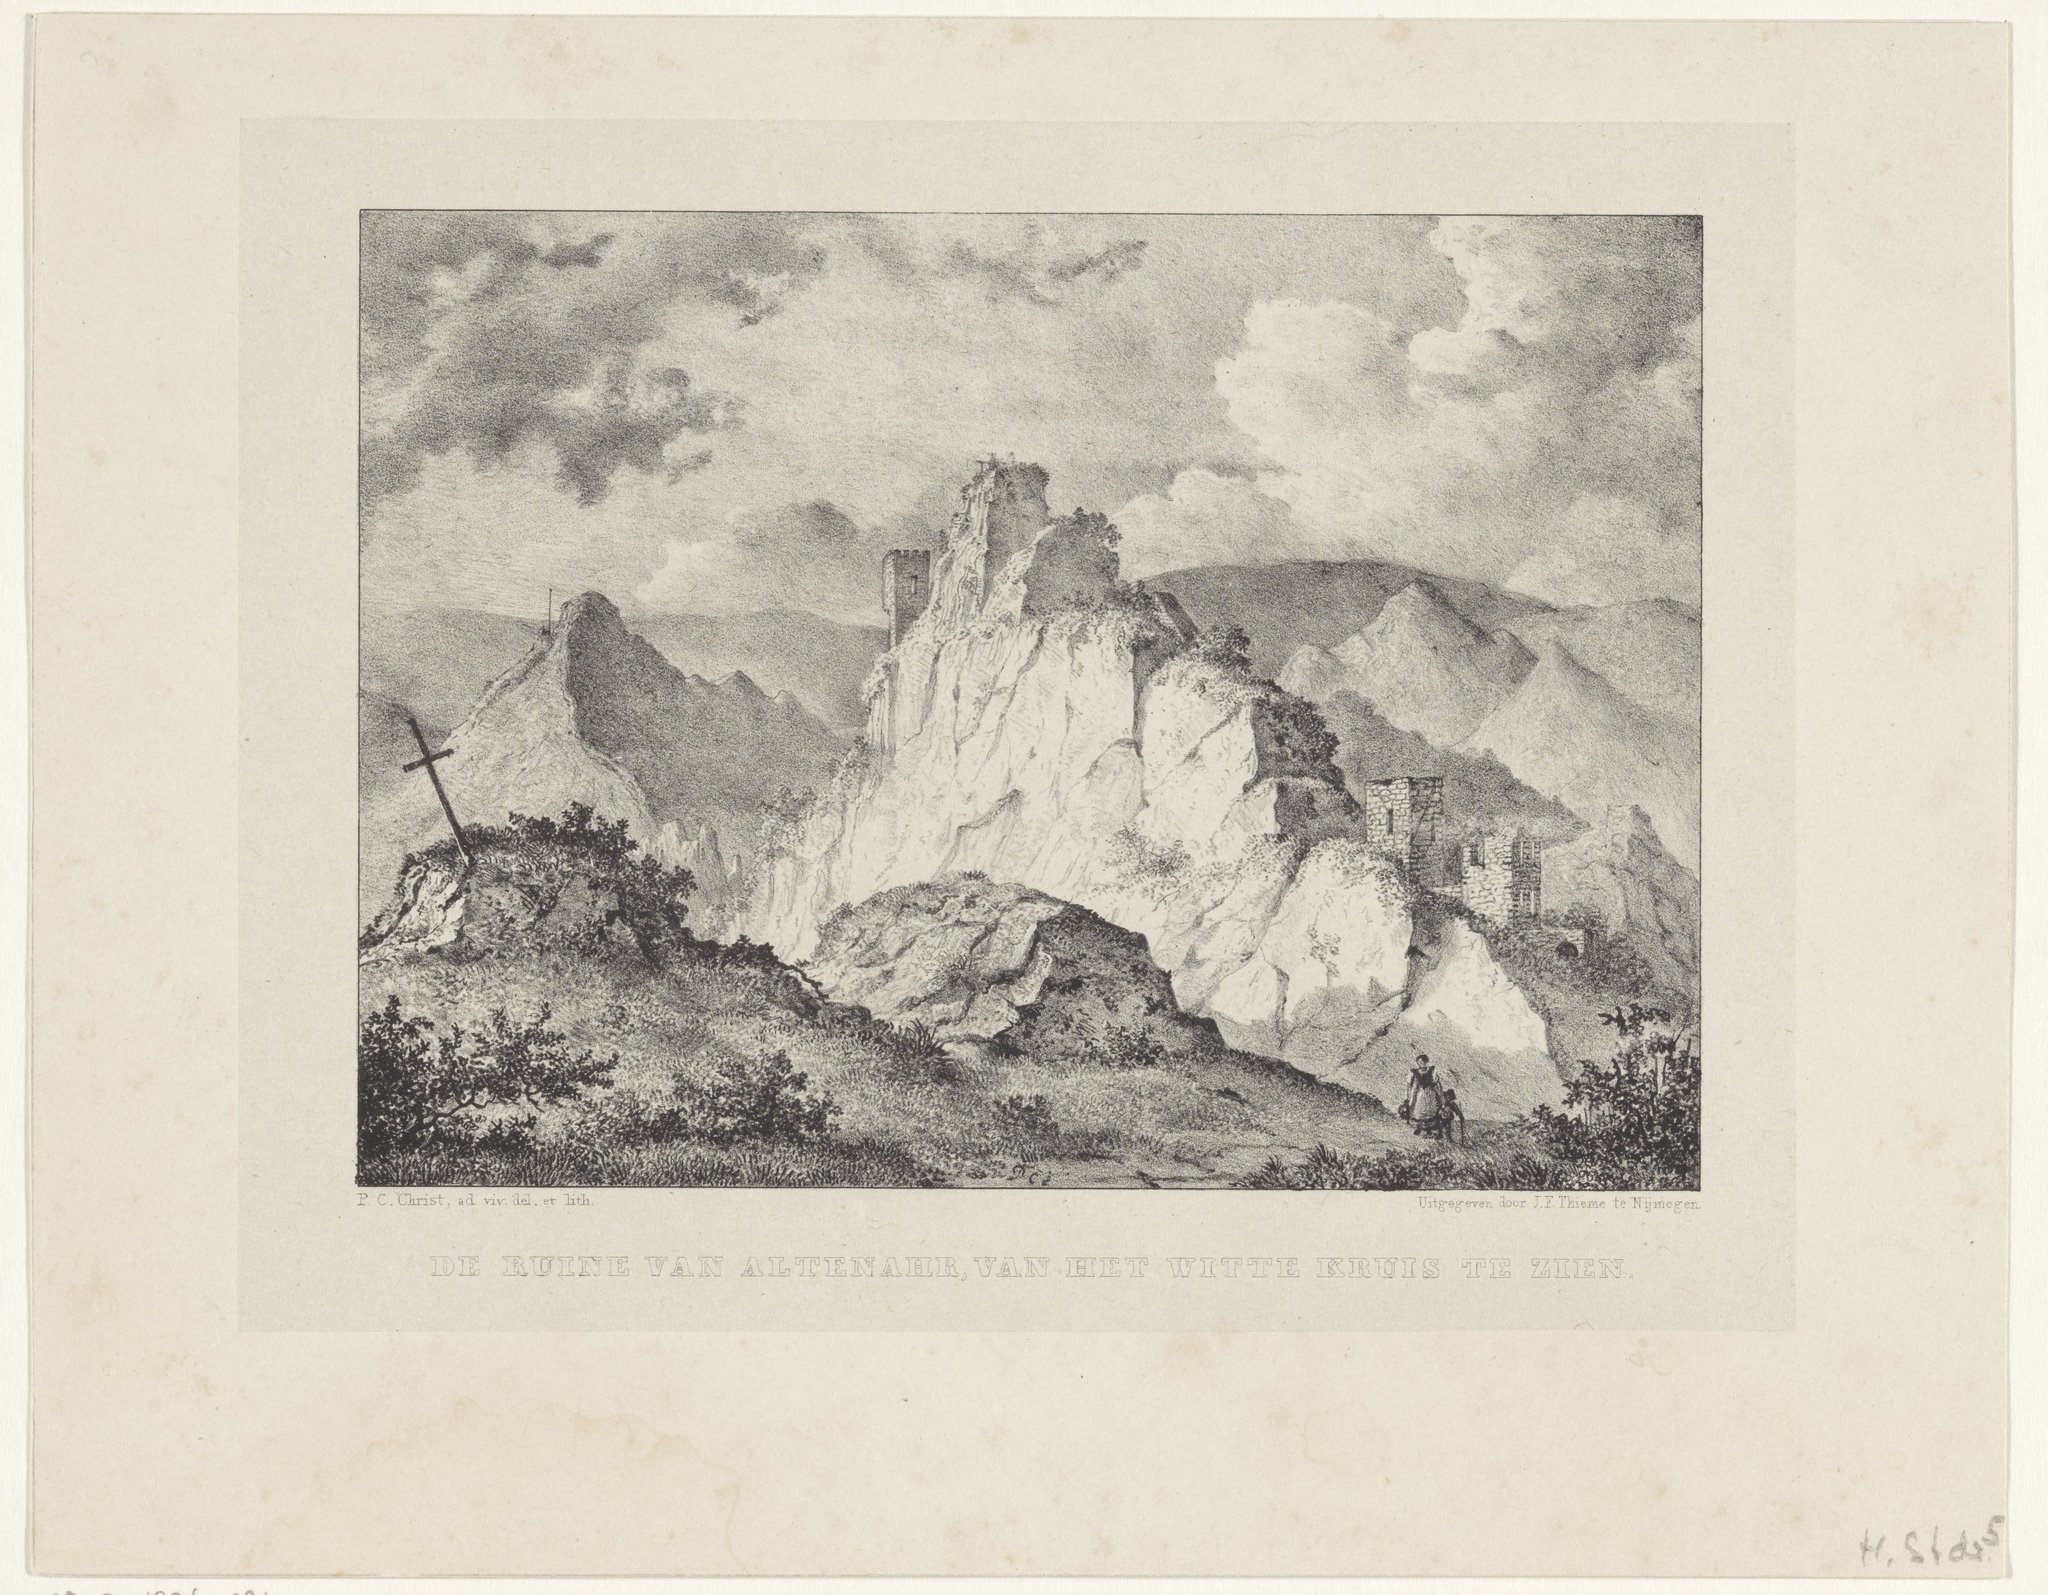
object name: print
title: De Ruine van Altenahr, van het Witte Kruis te zien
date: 1832-1888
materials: paper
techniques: lithograph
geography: nijmegen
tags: landscape with ruins, other kinds of grave-markers, e.g. cross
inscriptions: collector's mark: Lugt 2760, collector's mark: Lugt 2228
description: De ruïne staat op de top van een berg in een bergachtig landschap. Links in de voorgrond staat een kruis en rechts komen een vrouw en kind aangelopen over een zandweg.